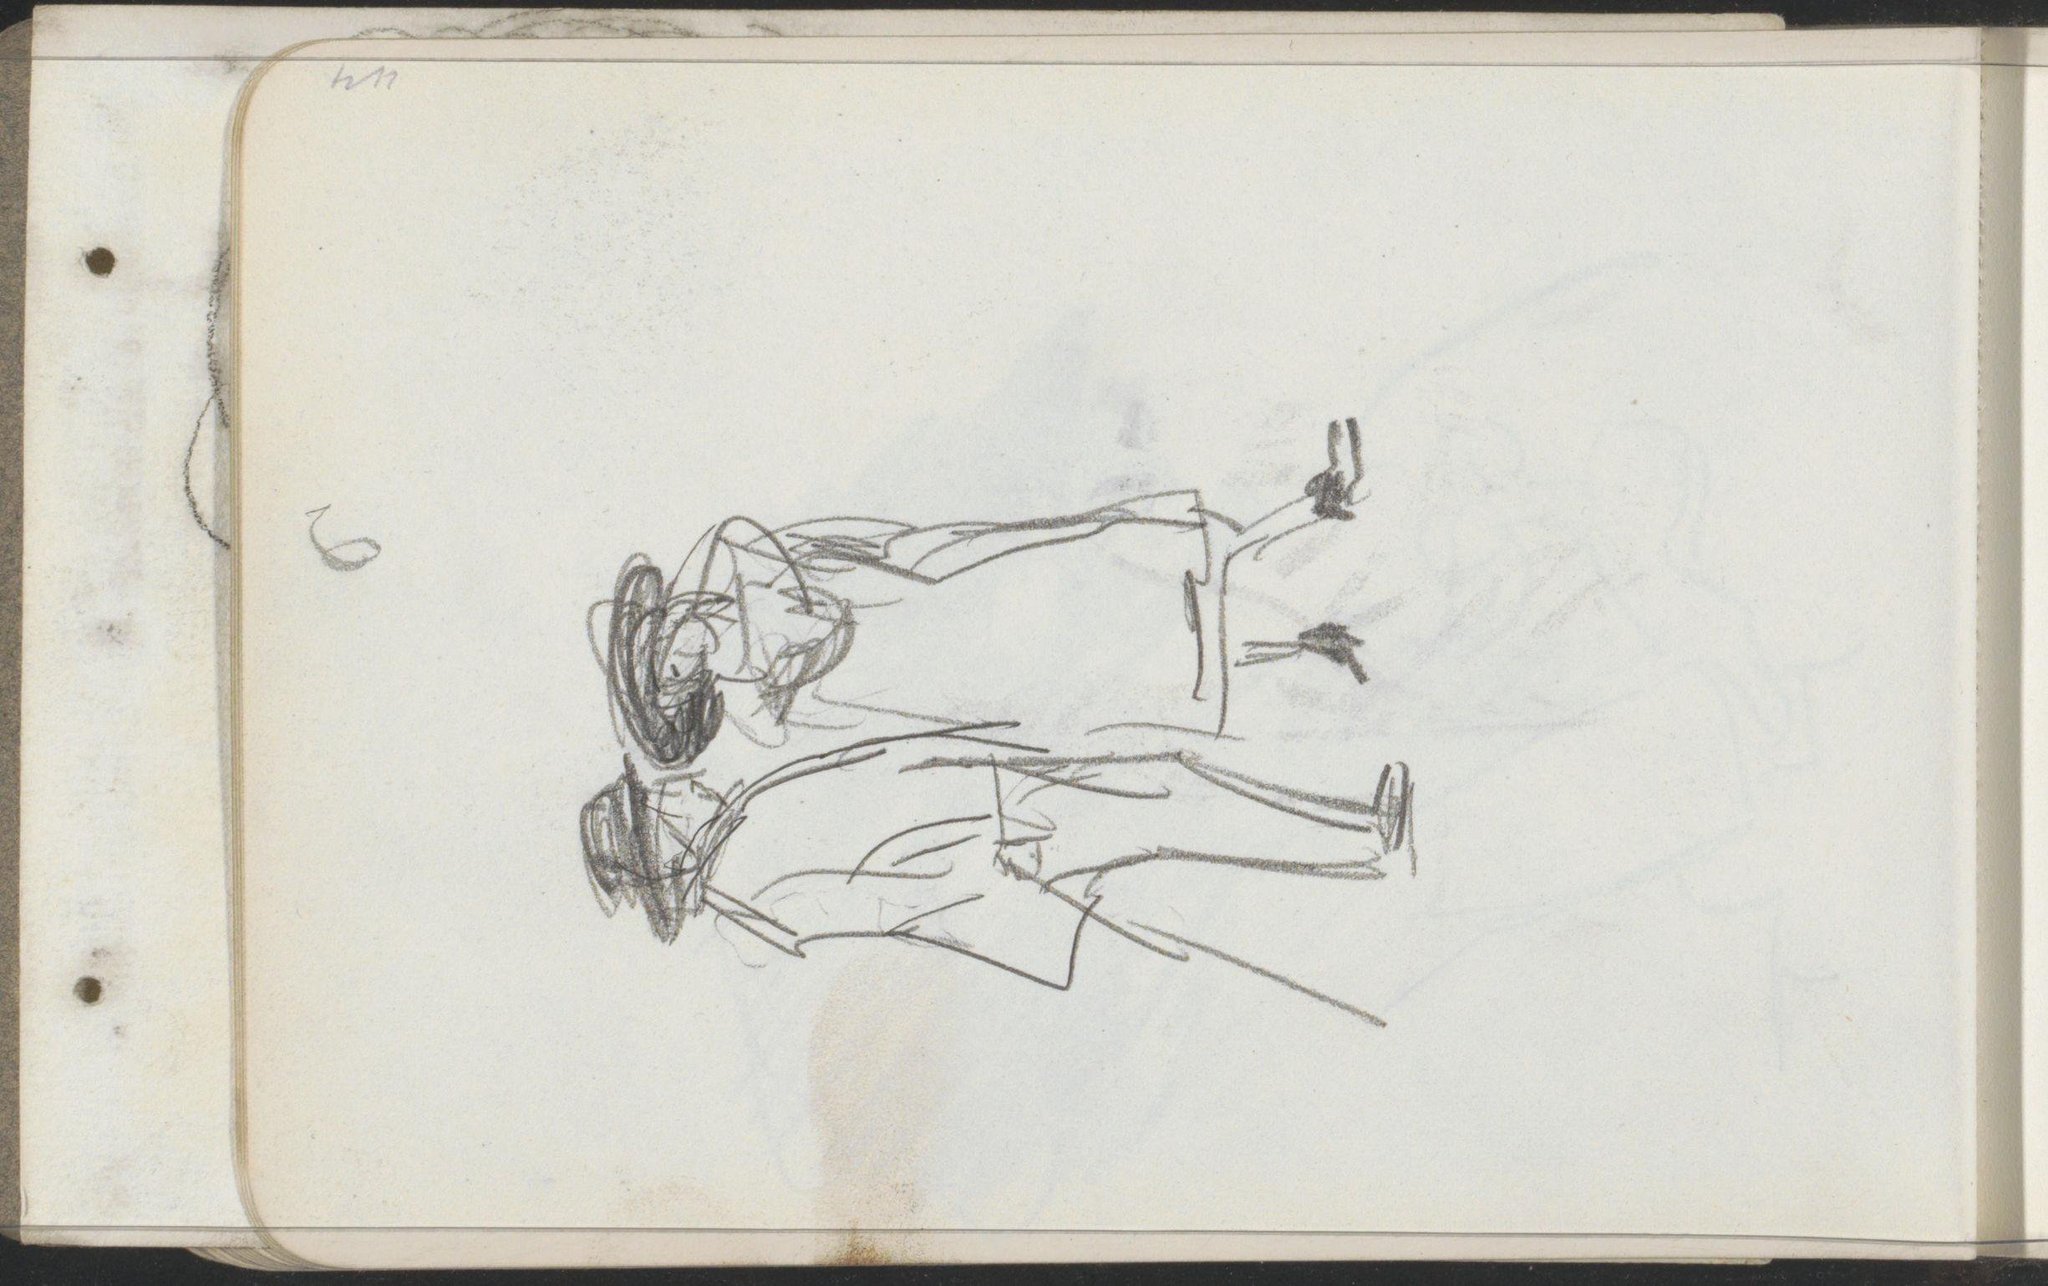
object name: sketchbook leaf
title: Staande man en vrouw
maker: isaac israels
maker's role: draughtsman, painter, print maker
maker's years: 1865-1934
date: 1875-1934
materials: paper, pencil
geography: the hague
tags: walking-stick, staff, adult woman (+ standing), adult man (+ standing)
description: Beiden dragen een hoed. De man leunt op een stok. Blad 23 verso uit schetsboek LX met 33 bladen.